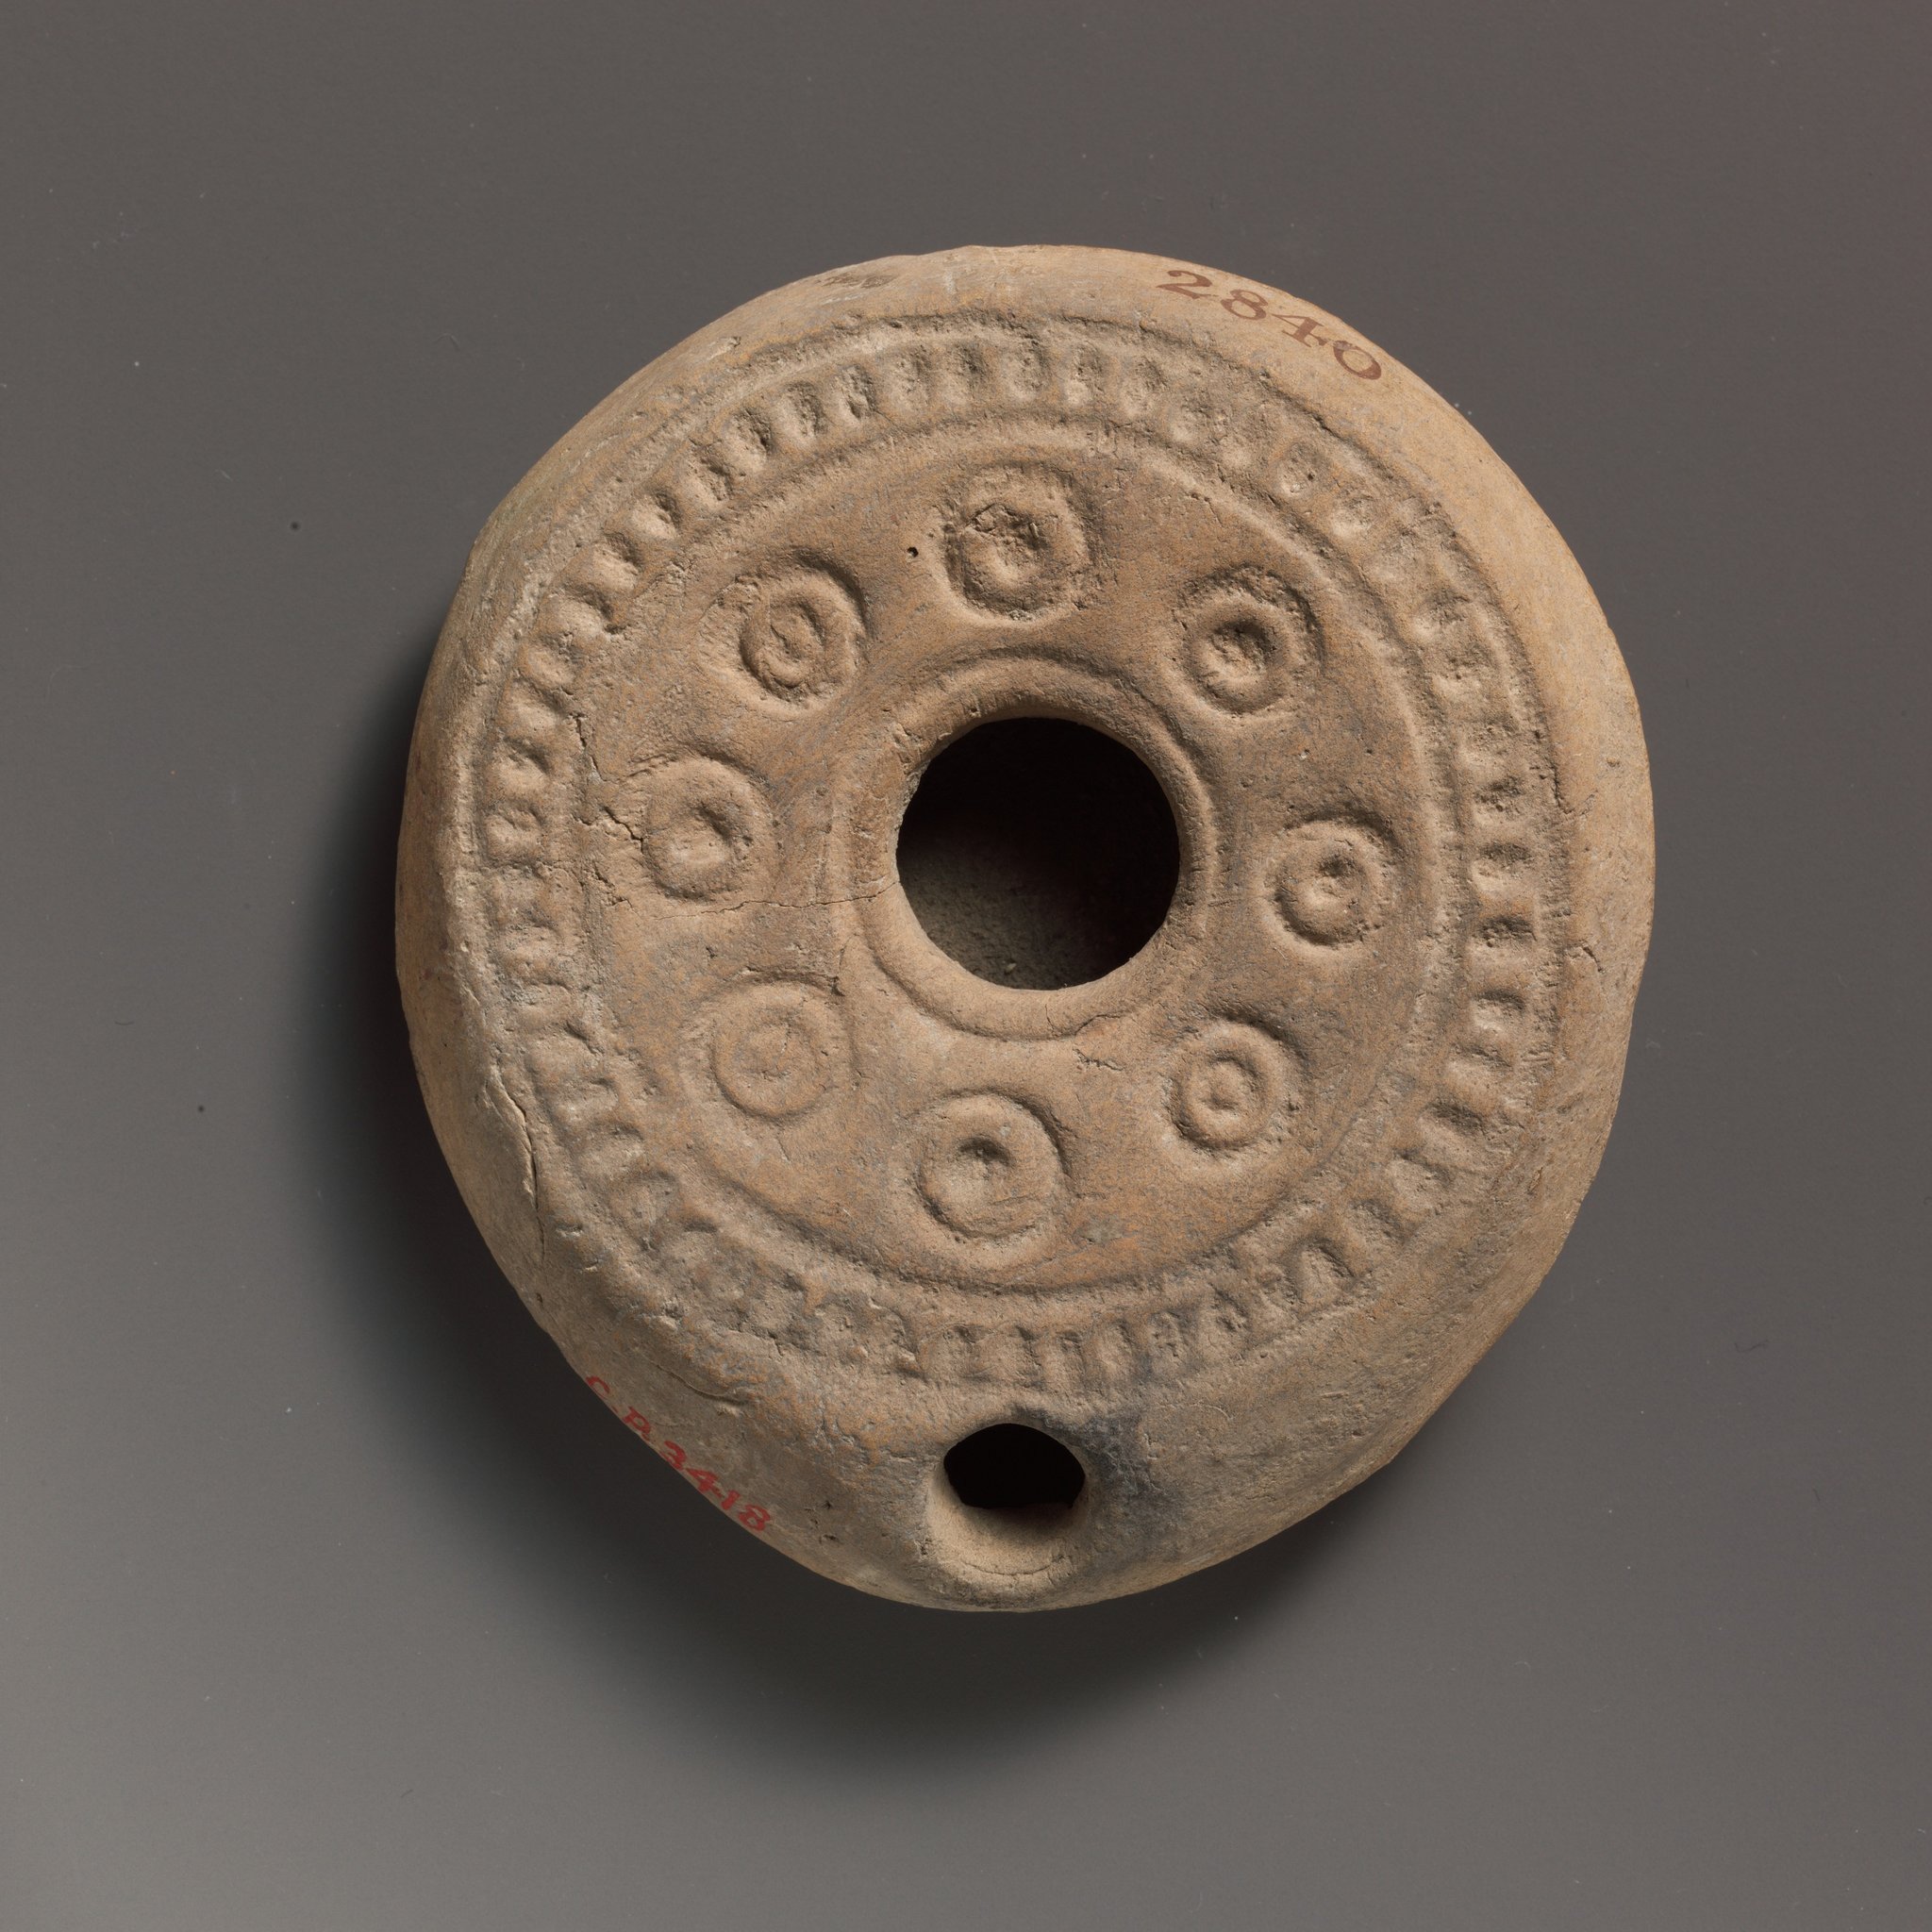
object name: lamp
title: Terracotta oil lamp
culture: roman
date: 467-600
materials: terracotta